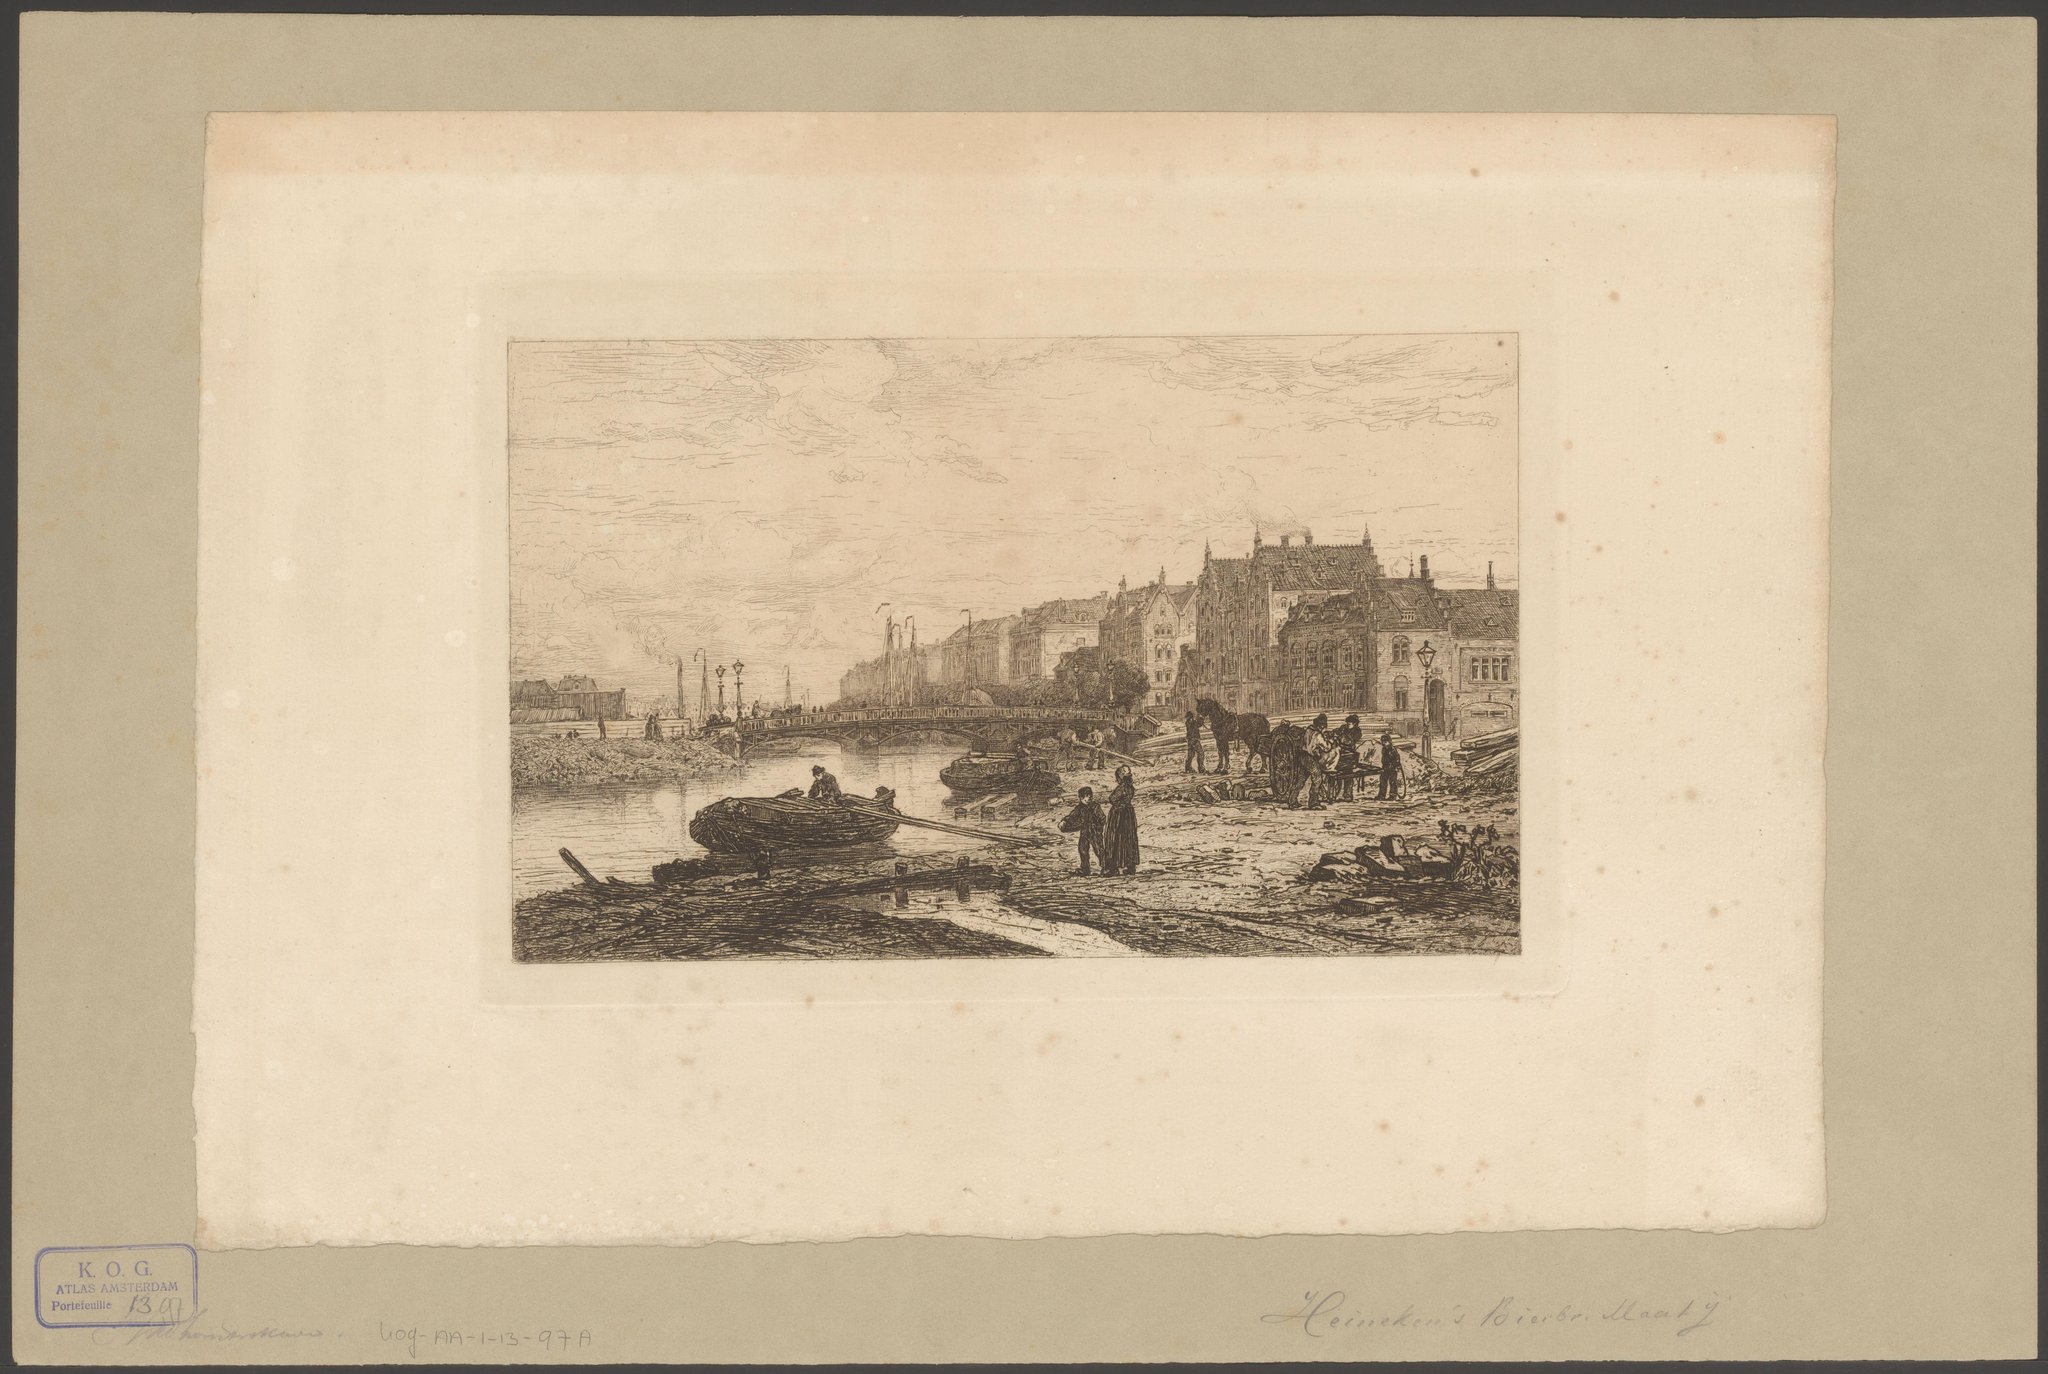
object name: print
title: Gezicht op Heineken's Bierbrouwerij aan de Stadhouderskade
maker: Anonymous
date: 1867-1950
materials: paper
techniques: drypoint, etching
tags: brewer, city-view in general; 'veduta', canal, the usual house or row of houses, bridge in city across river, canal, etc., street, boat propelled by man or animal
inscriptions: inscription: ‘Stadhouderskade / Heineken's Bierbr. Maatij’, collector's mark: ‘13,97’ Lugt 1641b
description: Onderwerpsrubriek binnen de Atlas Amsterdam: Slatuinenpad, Sloterkade, Slootstraat, Slijkstraat, Snoekjesgracht, Sophiapark, Spaarndammerdijk, Spiegelgracht, Spinhuissteeg, Spui, Spuistraat (ook lage Erf), Staalstraat, Stadhouderskade, Steenpad, Stroomarkt.